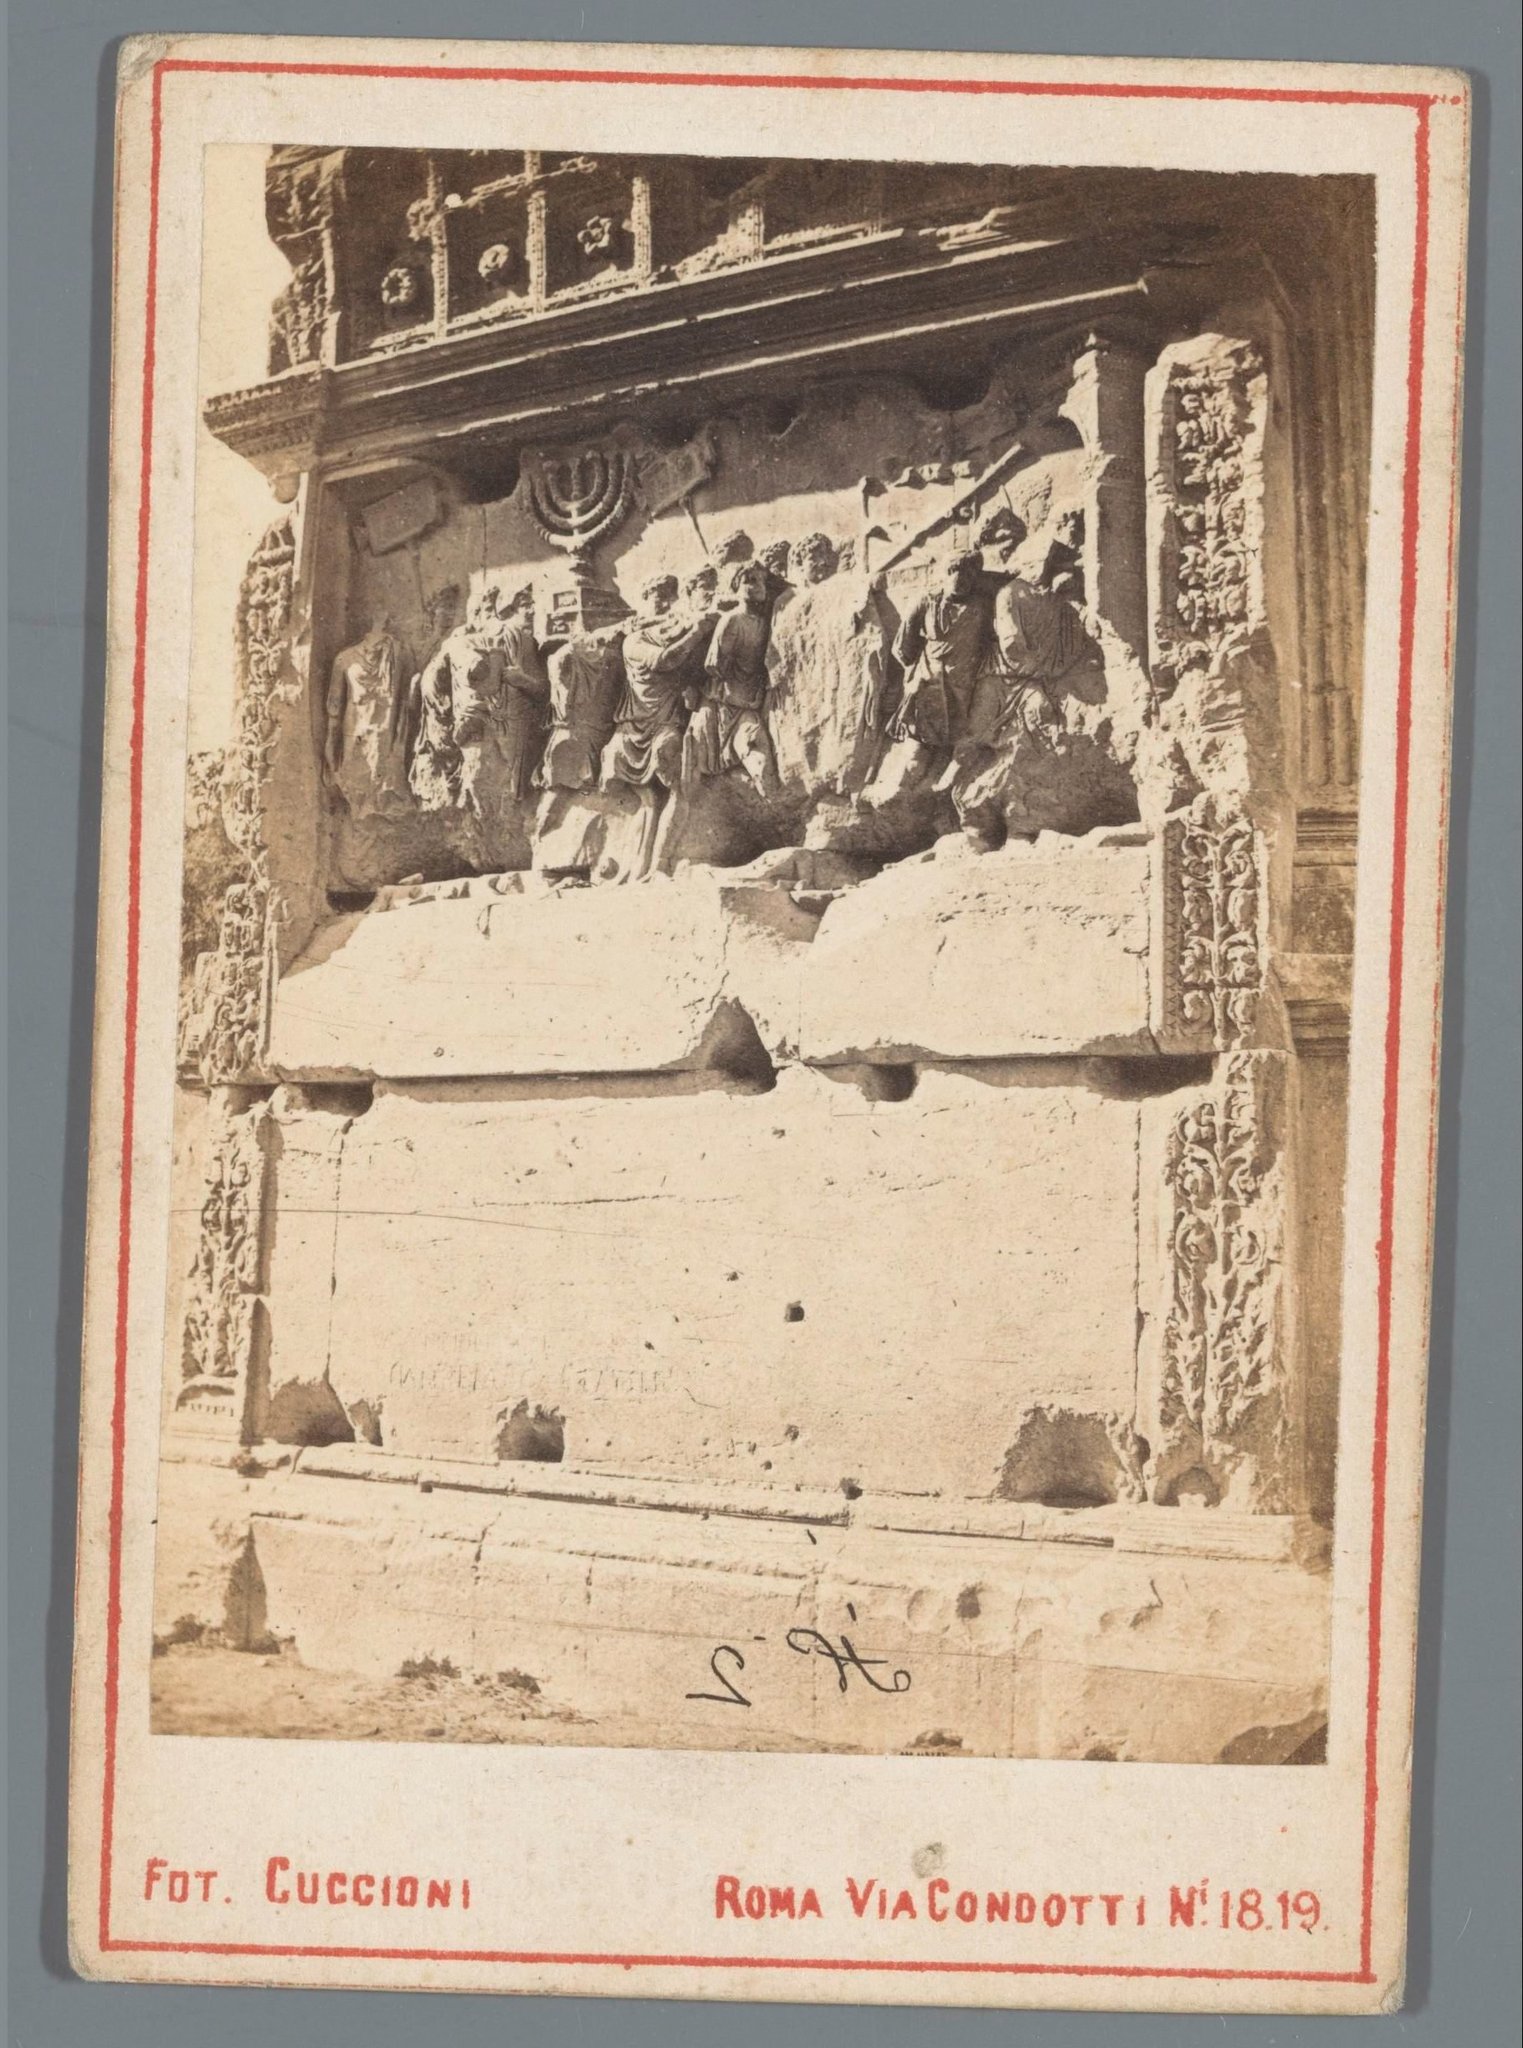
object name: carte de visite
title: Reliëf in de Boog van Titus, Rome: krijgsbuit uit de Tempel van Jeruzalem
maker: tomasso cuccioni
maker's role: print maker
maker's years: 1790-1864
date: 1855-1885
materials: cardboard, paper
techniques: albumen print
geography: rome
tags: triumphal arch, emperor titus destroying the temple of jerusalem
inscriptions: inscription: ‘Roma Via Condotti Ni. 18.19.’, inscription: ‘Basrelief de l'arc de Titus/ (Rome)’, inscription: ‘H 2’